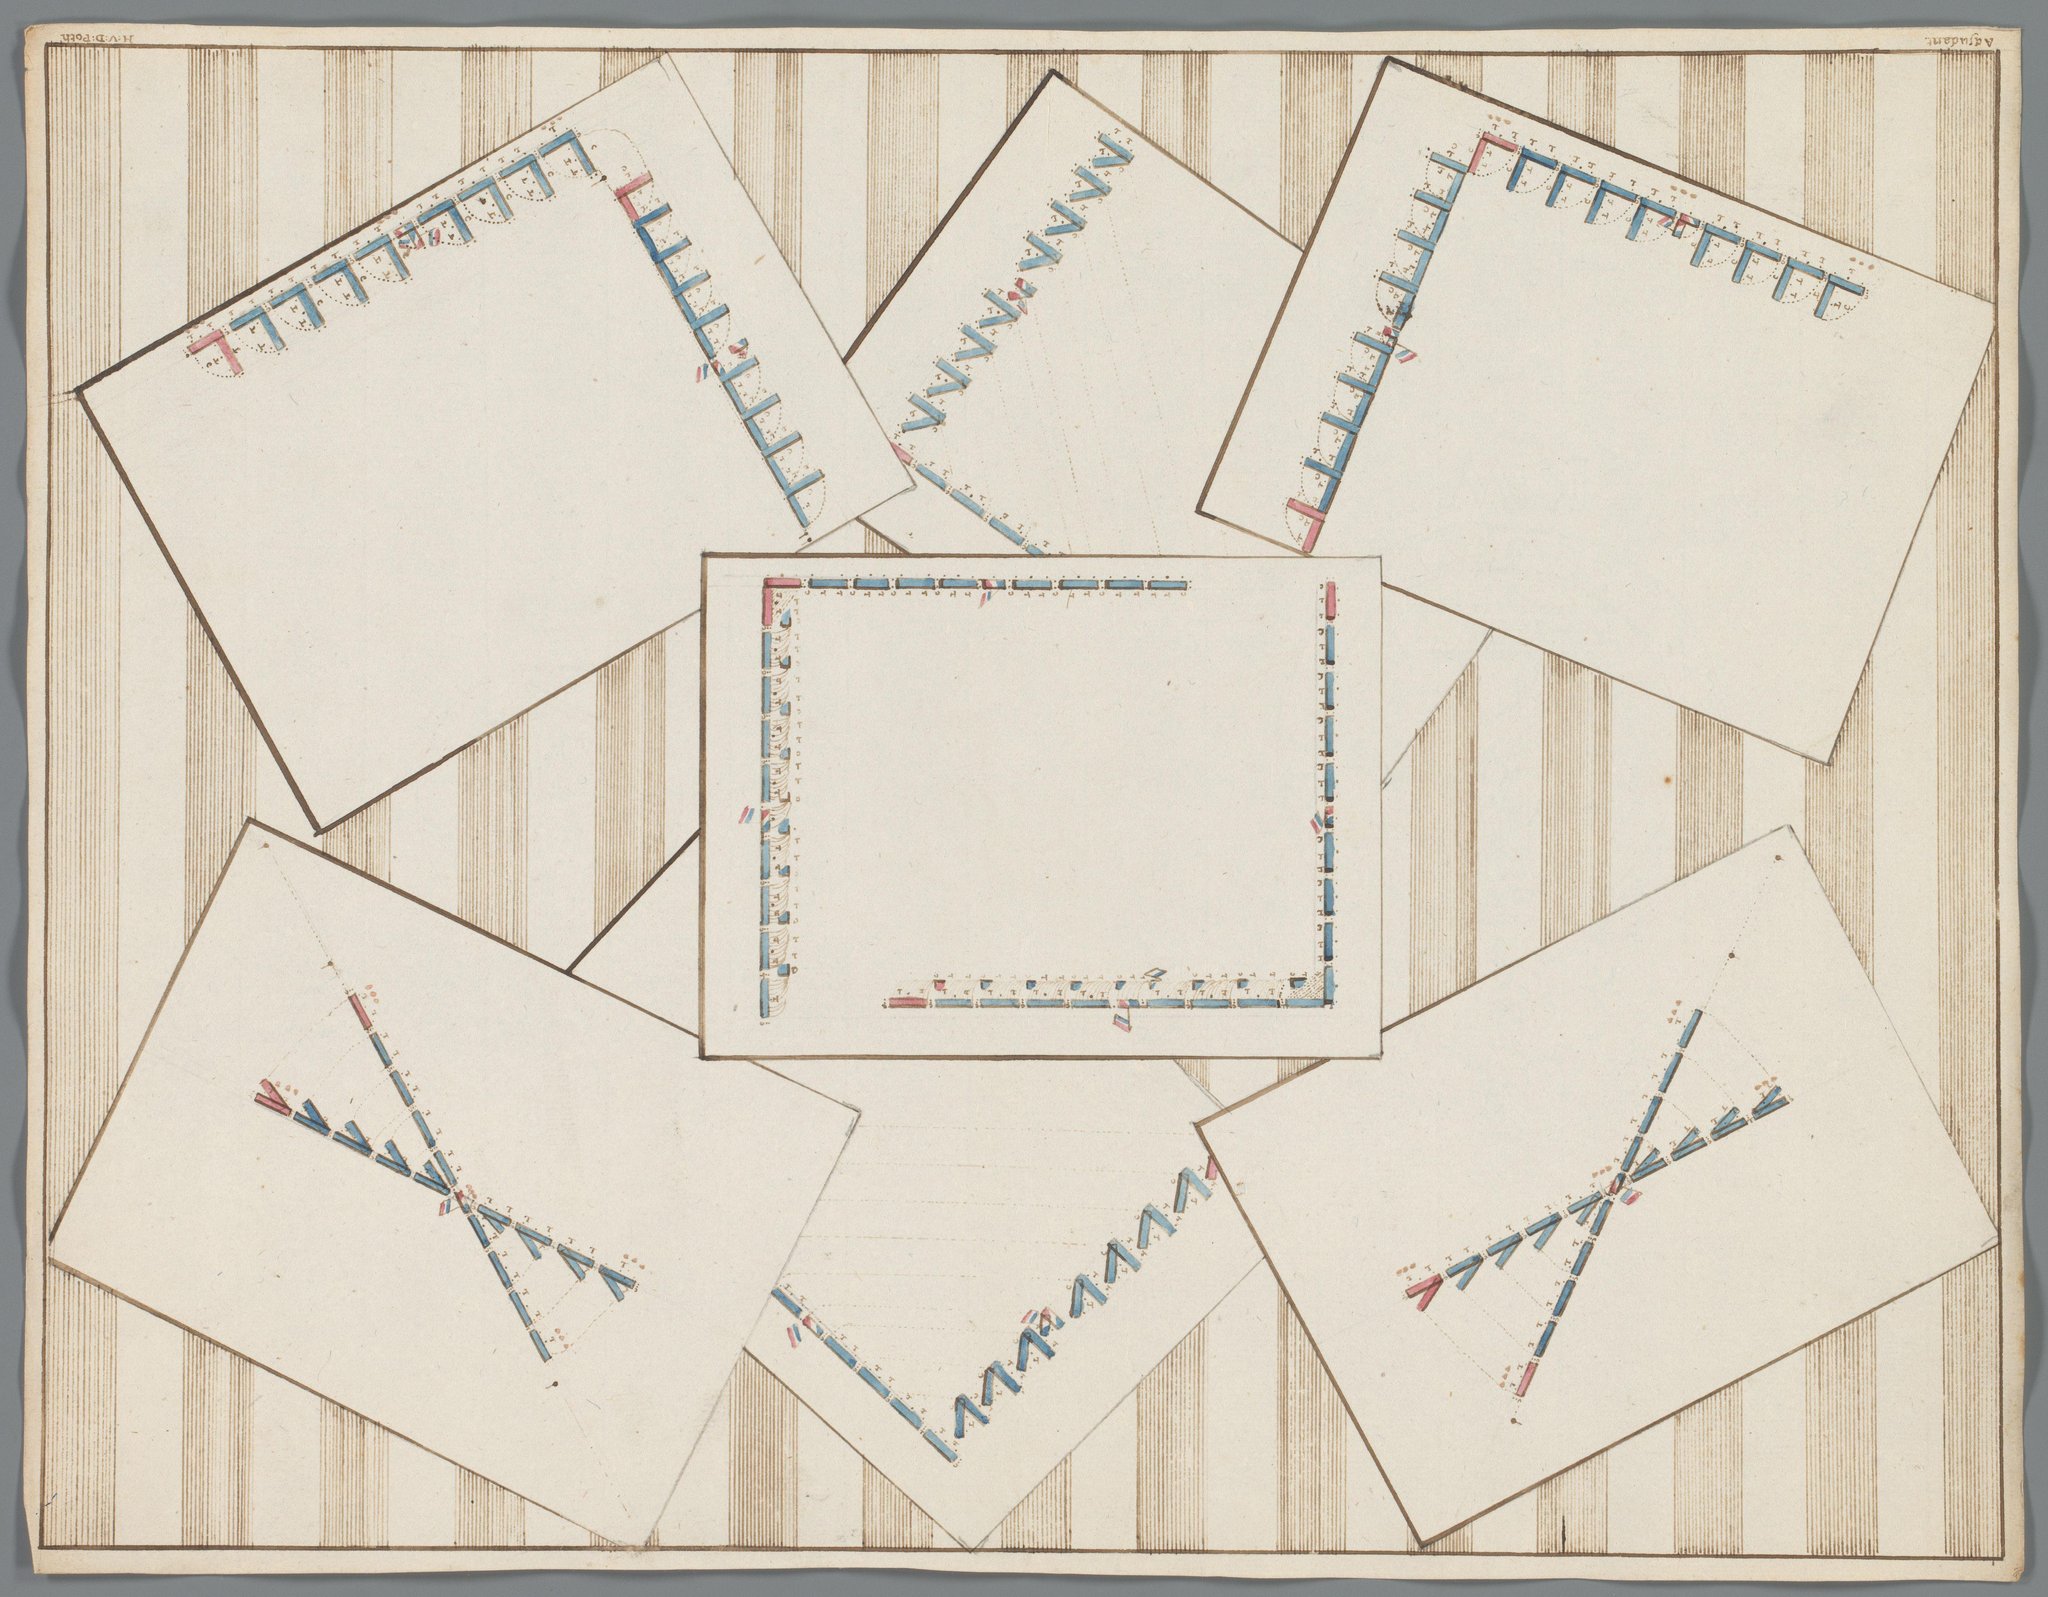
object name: drawing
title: Manoeuvres van de compagnieën, ca. 1799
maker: hendrik van der poth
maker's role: draughtsman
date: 1799-1803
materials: paper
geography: netherlands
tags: manoeuvre ~ military training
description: Blad met zeven kaartjes van verschillende manoeuvres van de zeven compagnieën van het Bataafse bataljon. Ten tijde van de Brits-Russische expeditie in 1799. Onderdeel van een groep van zeventien getekende kaarten.